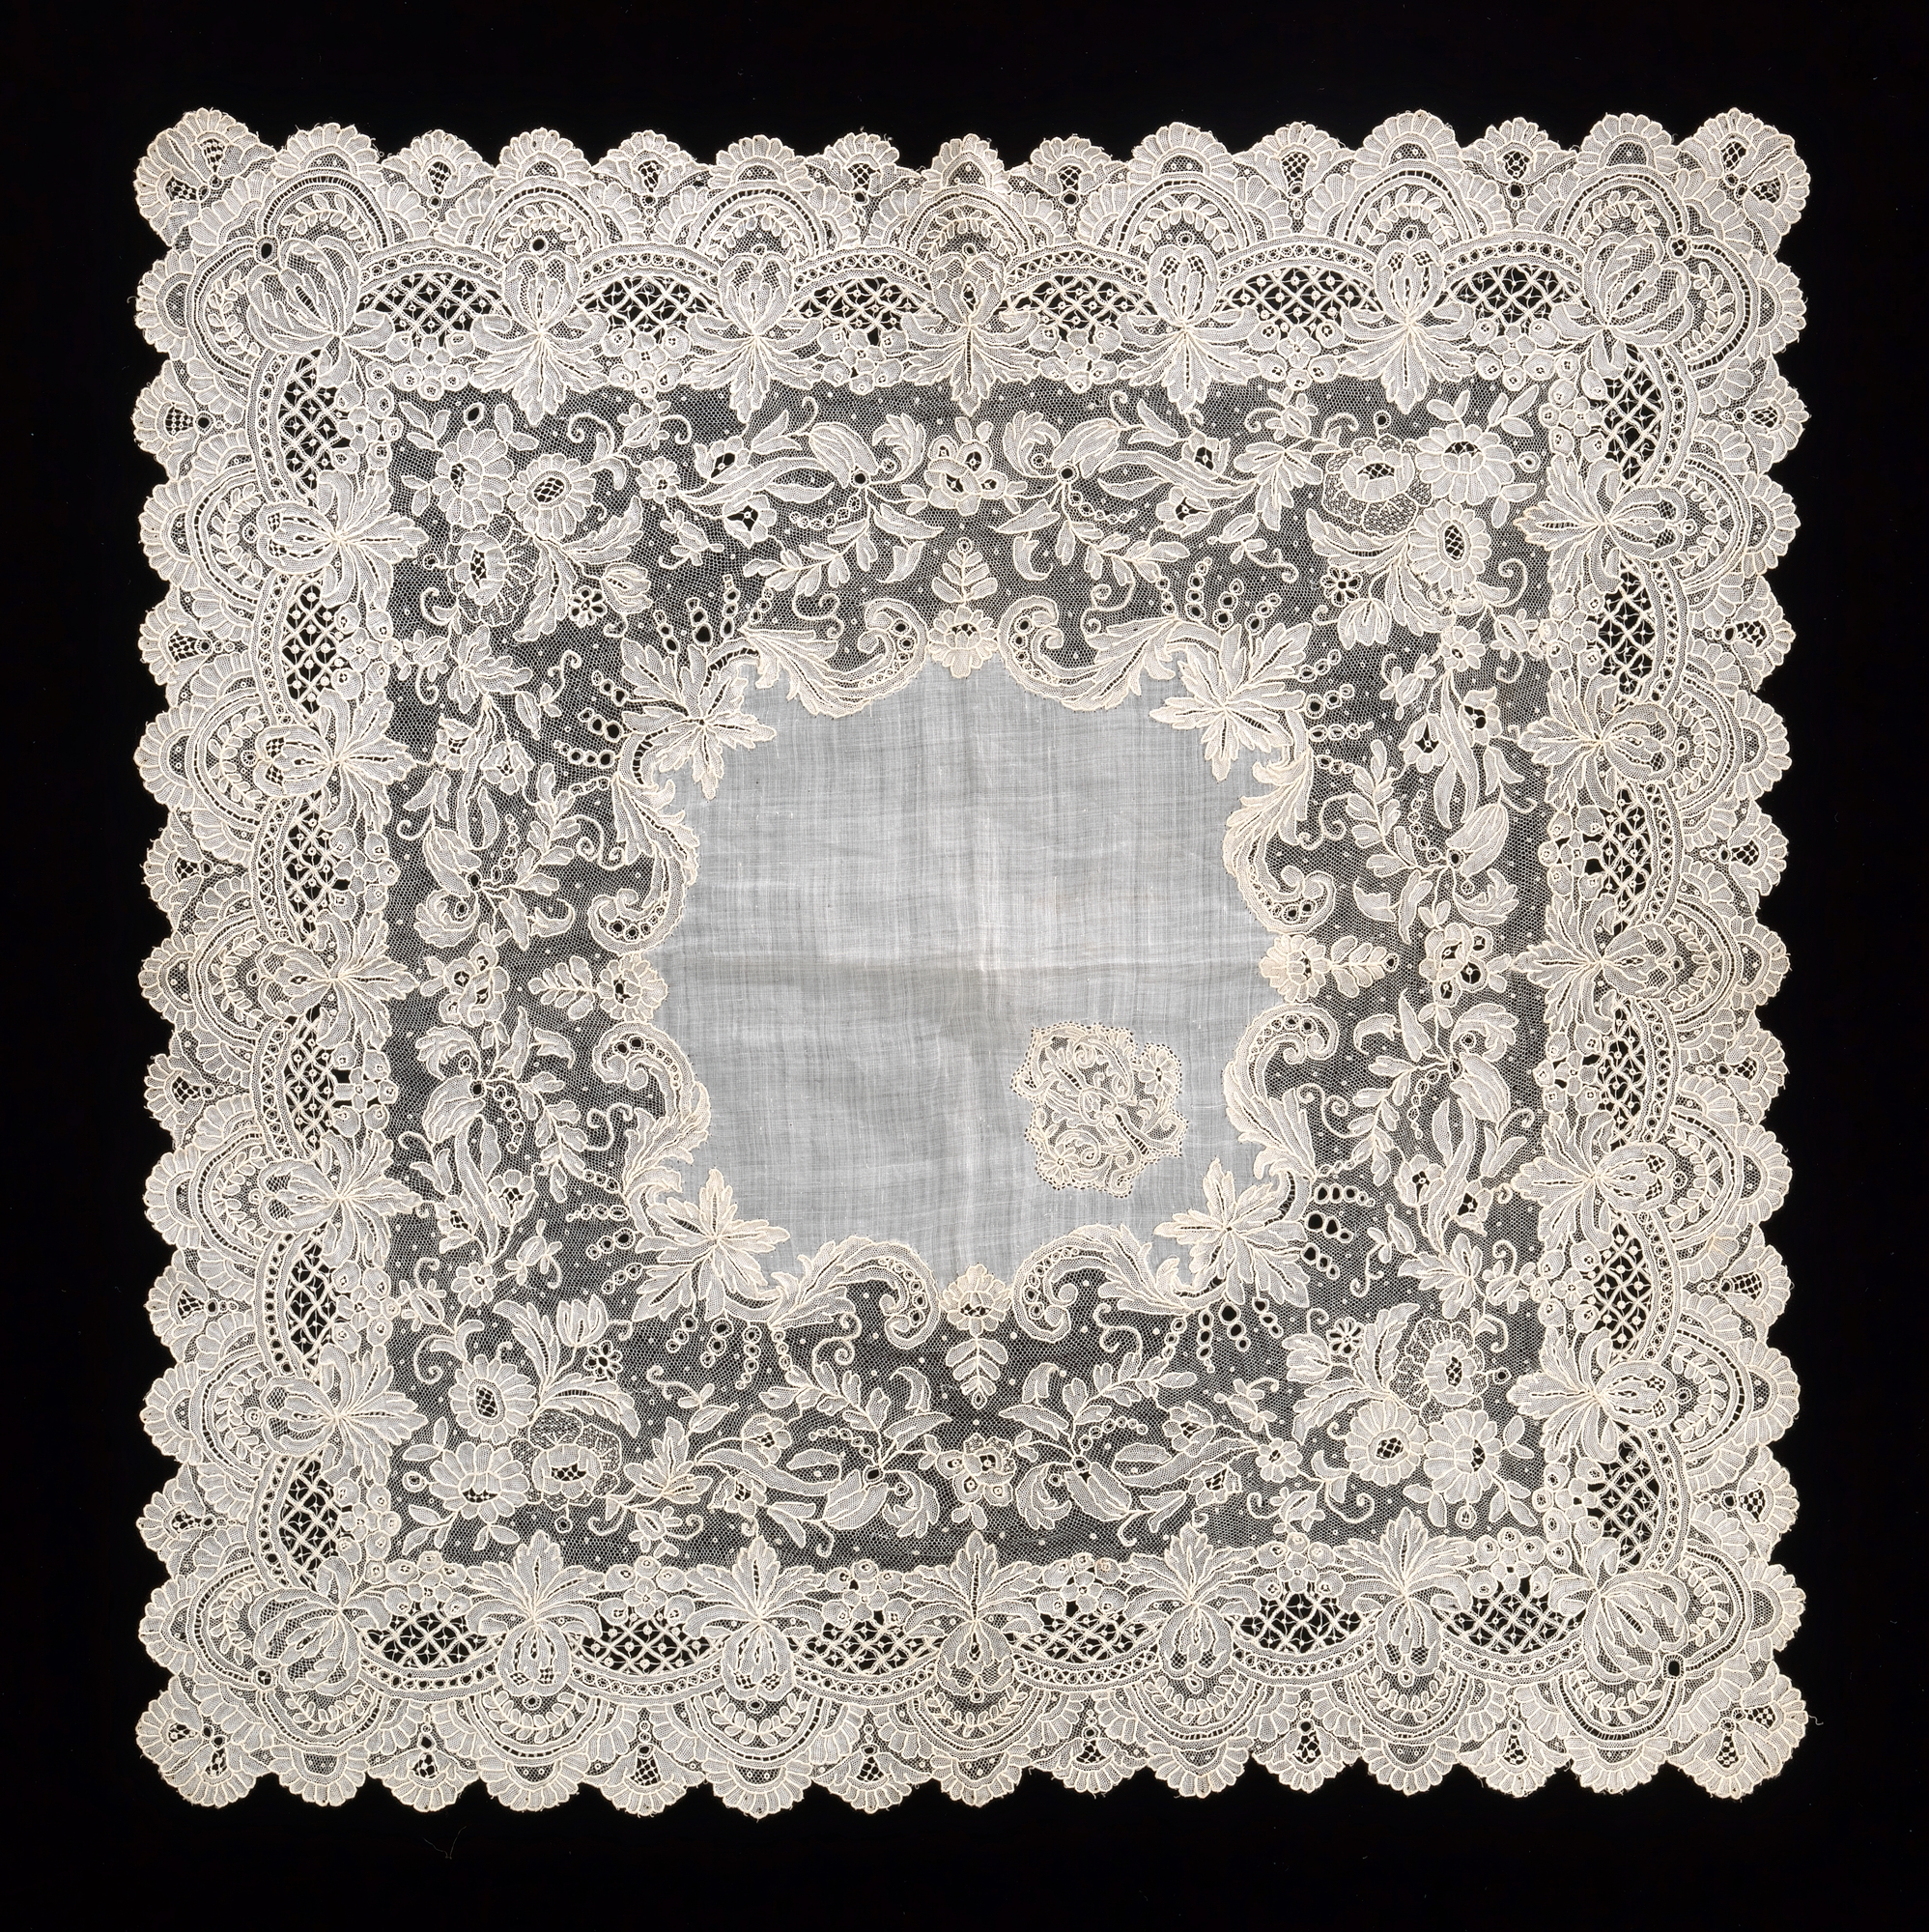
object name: handkerchief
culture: french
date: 1851-1875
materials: cotton, linen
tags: flowers